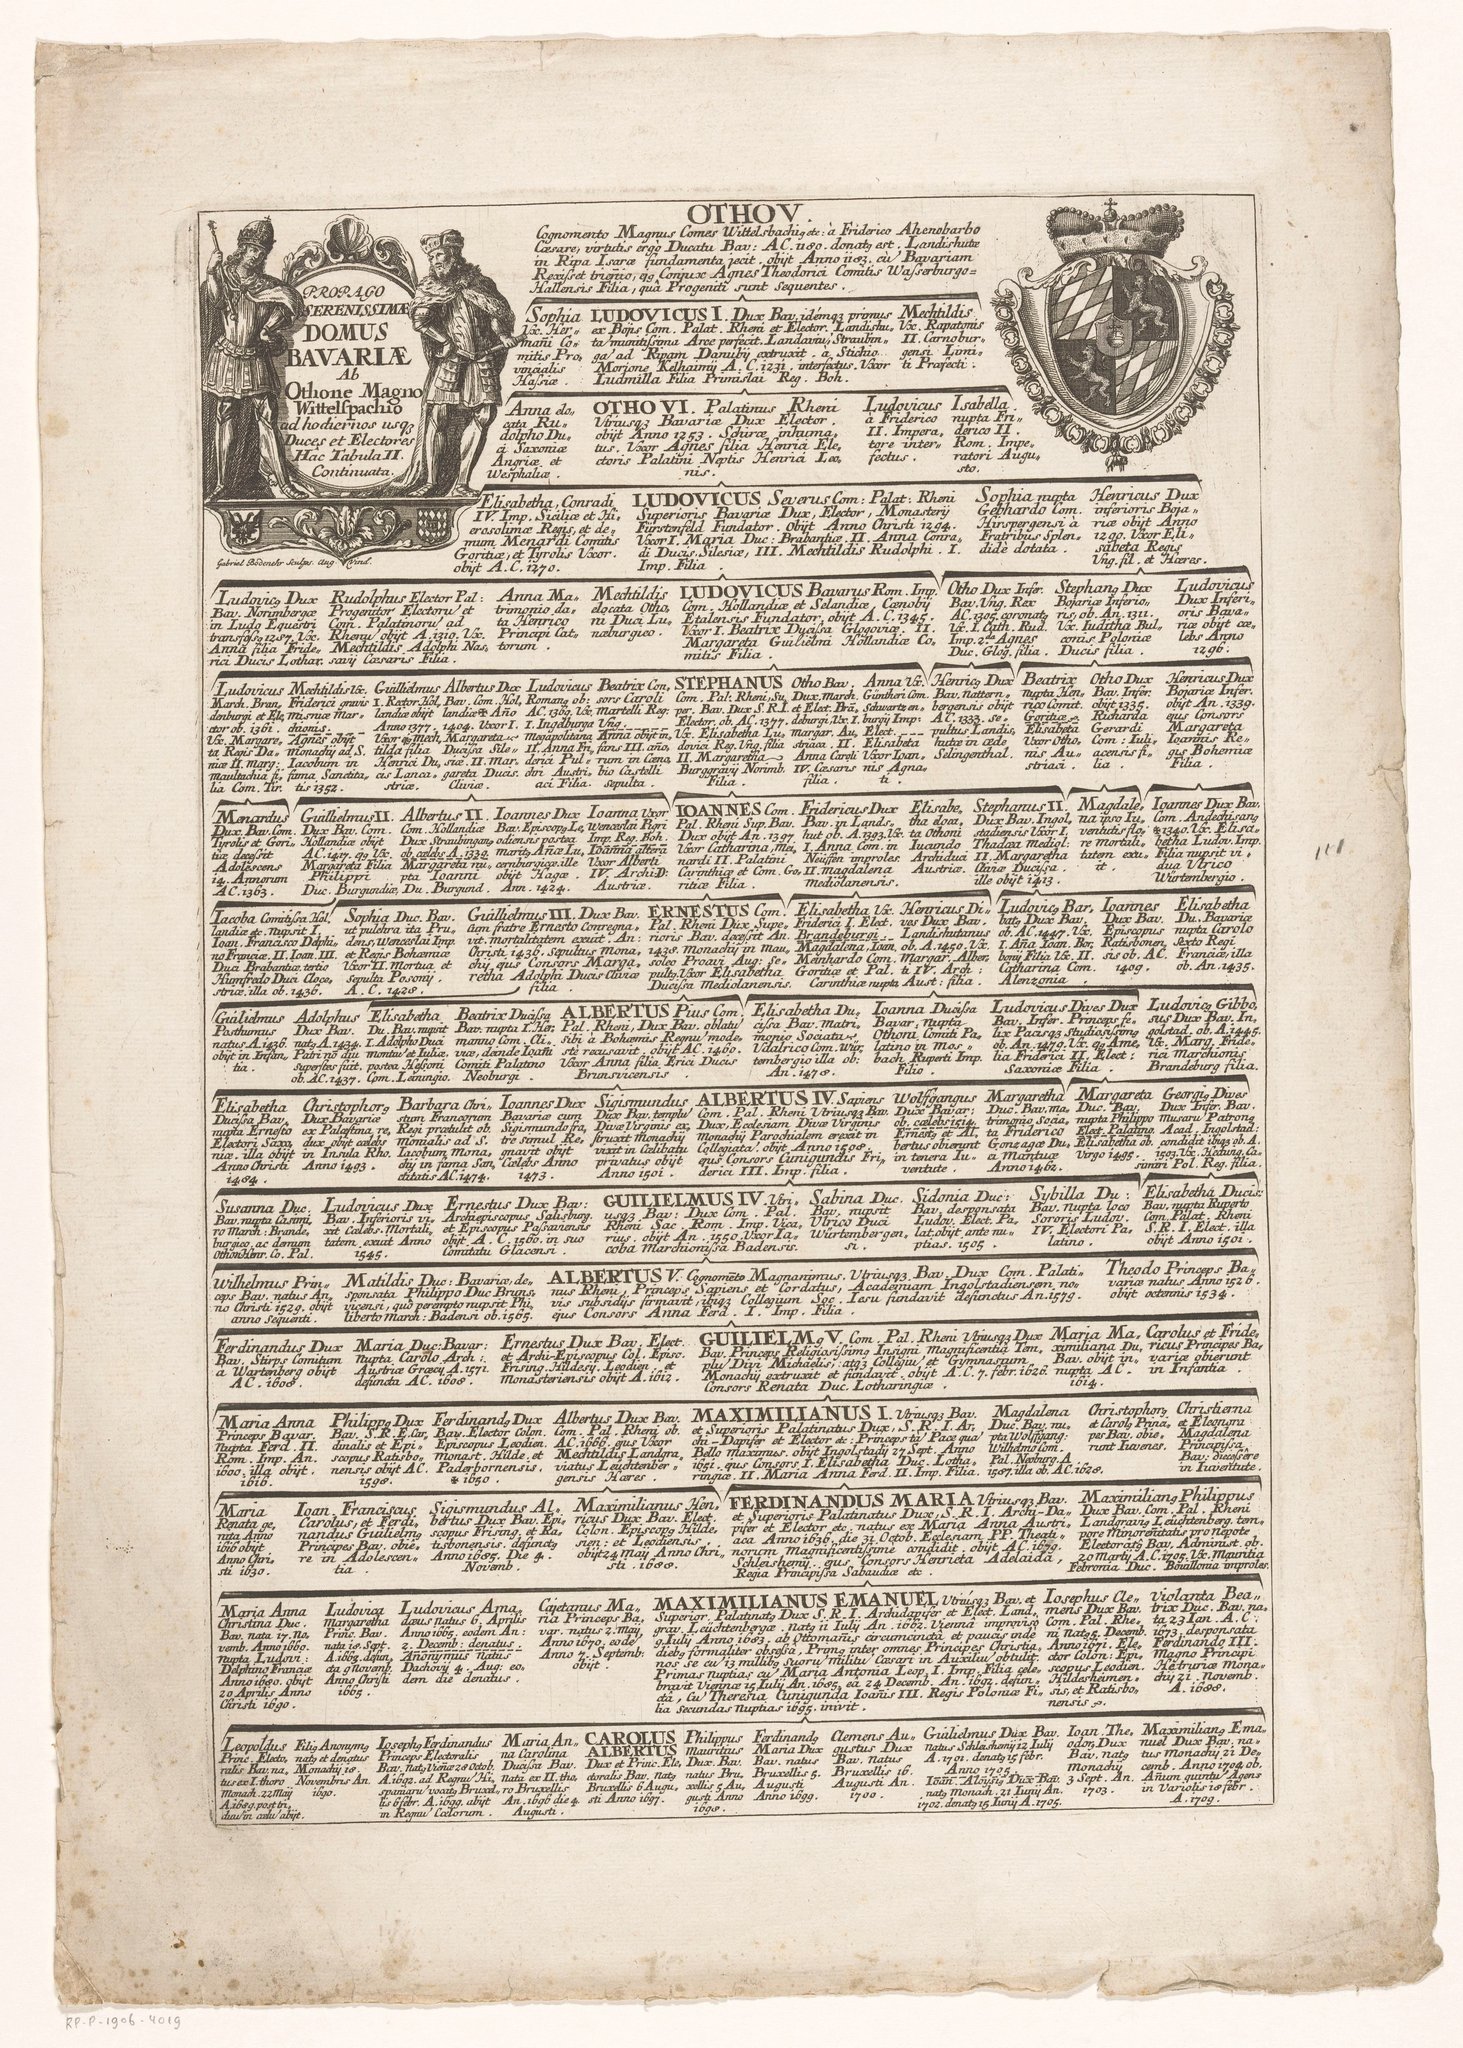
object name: print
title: Stamboom van het Beierse vorstenhuis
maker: gabriel bodenehr (i)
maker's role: print maker, publisher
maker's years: 1673-1765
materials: paper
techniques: etching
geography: nuremberg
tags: family lineage, pedigree, genealogical tree or table, ruler, sovereign, armorial bearing, heraldry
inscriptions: collector's mark: Lugt 2228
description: Eerste deel van een tweedelige stamboom van het Beierse vorstenhuis.